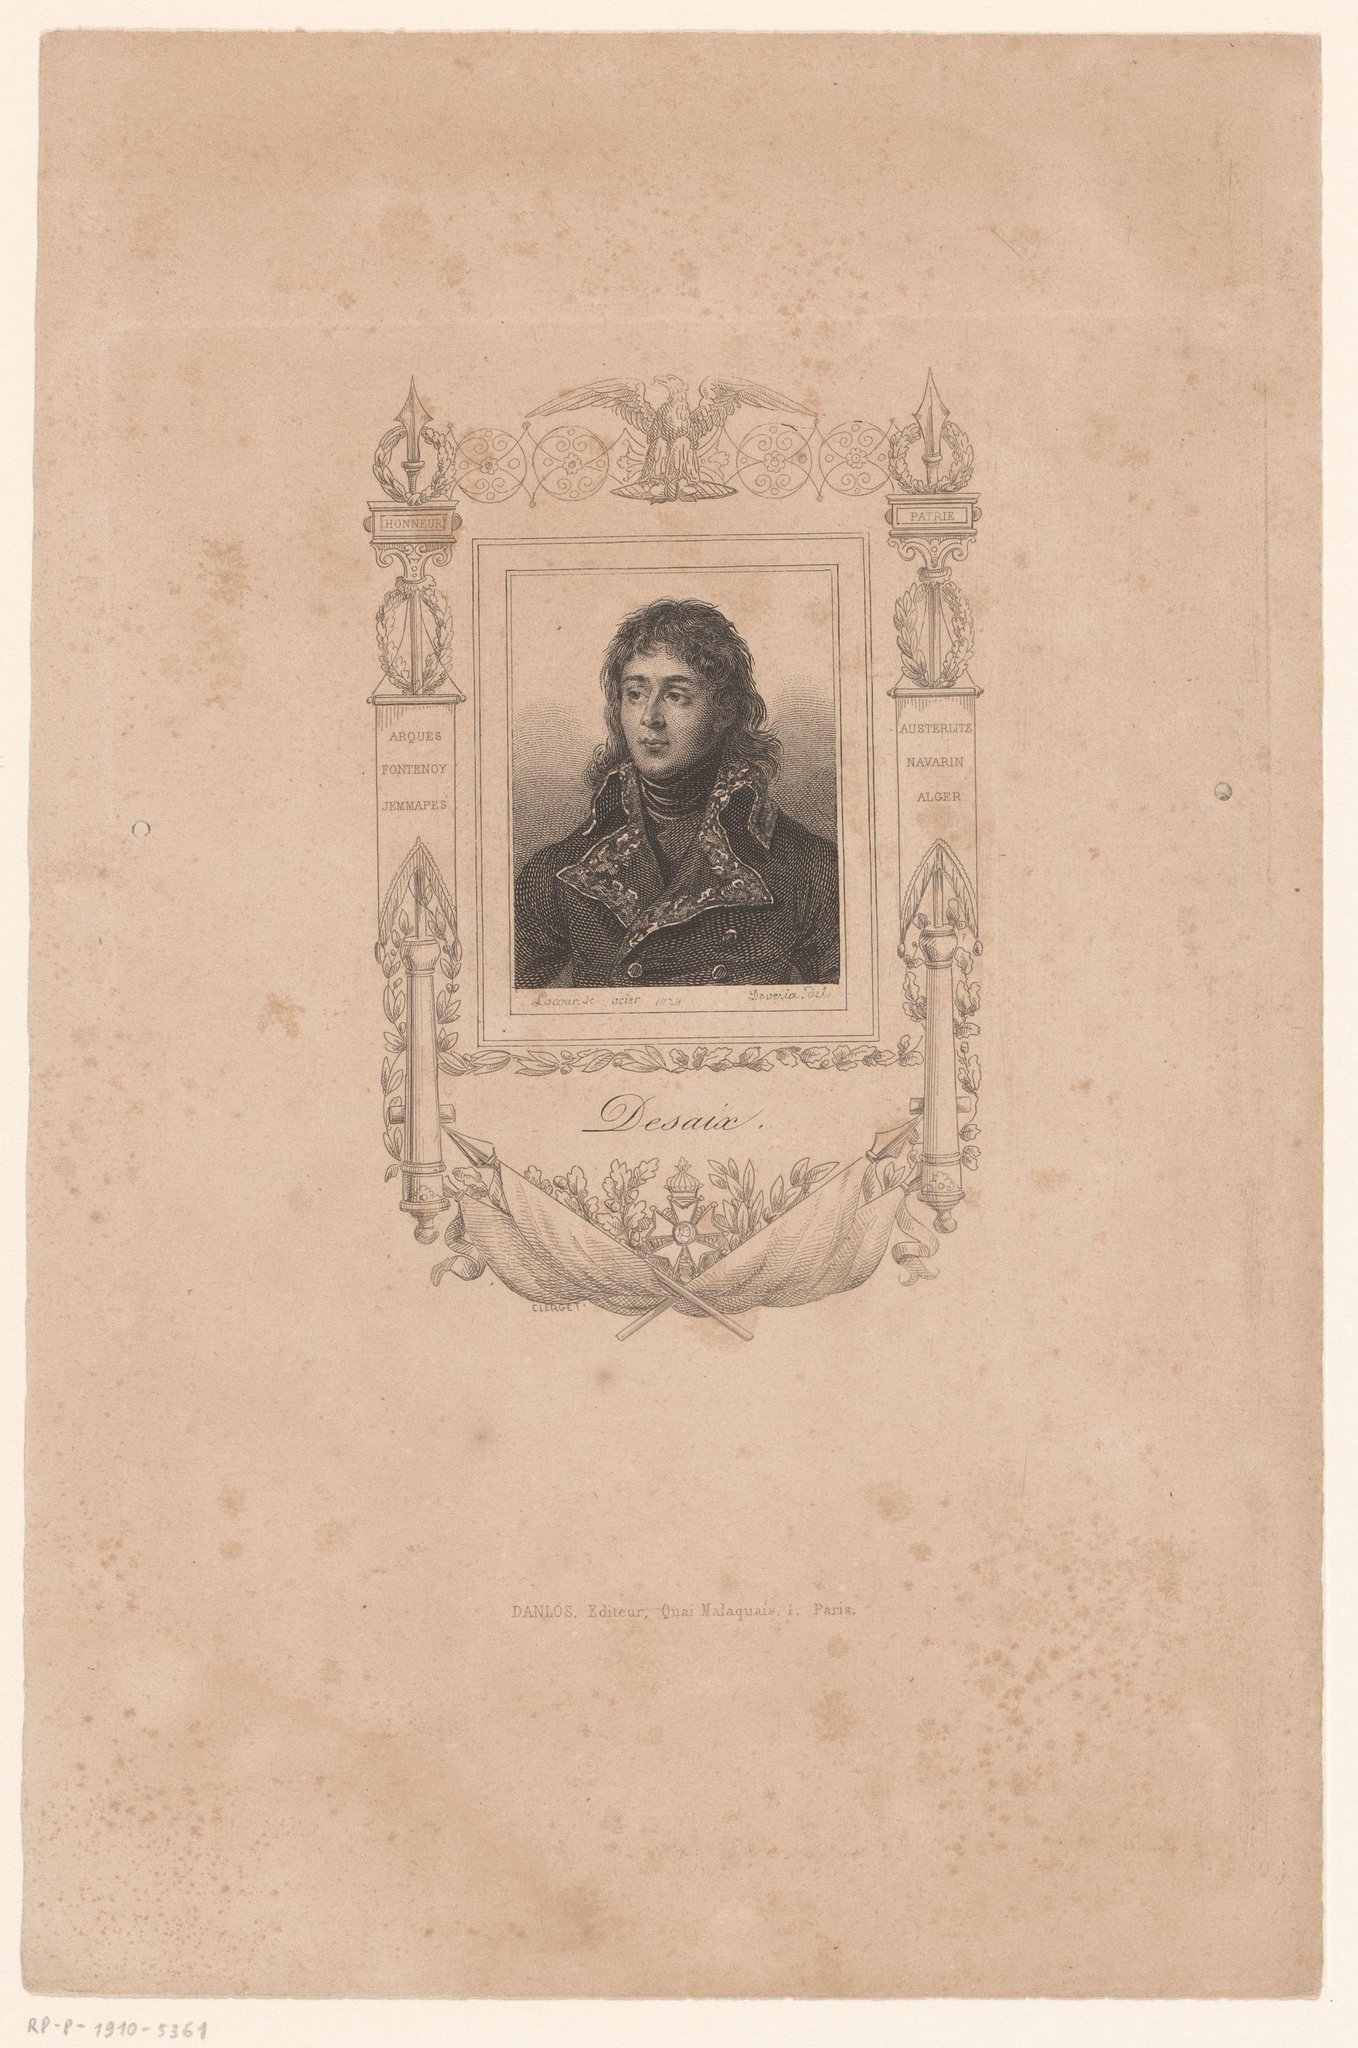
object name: print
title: Portret van Louis-Charles-Antoine Desaix in een versierde cartouche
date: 1828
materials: paper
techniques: engraving, etching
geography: paris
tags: commander-in-chief, general, marshal, historical persons, ornament ~ cartouche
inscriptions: collector's mark: Lugt 2228